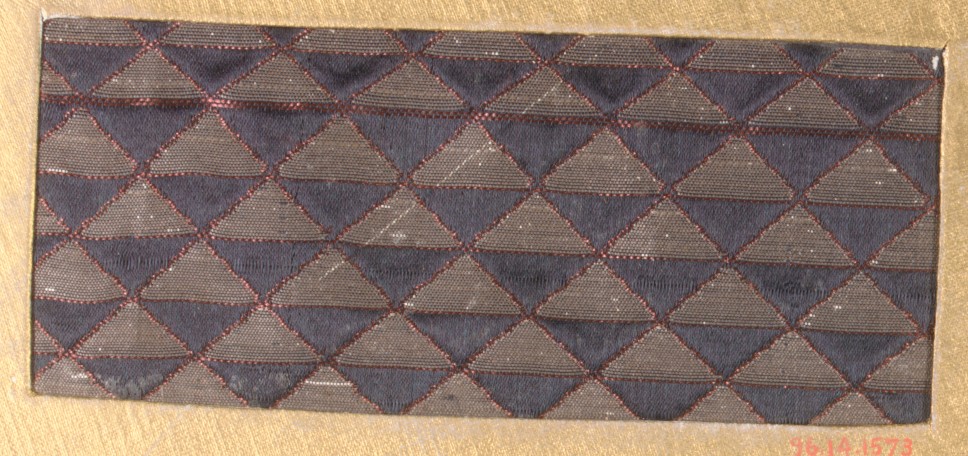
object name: piece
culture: japanese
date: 1701-1900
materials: silk